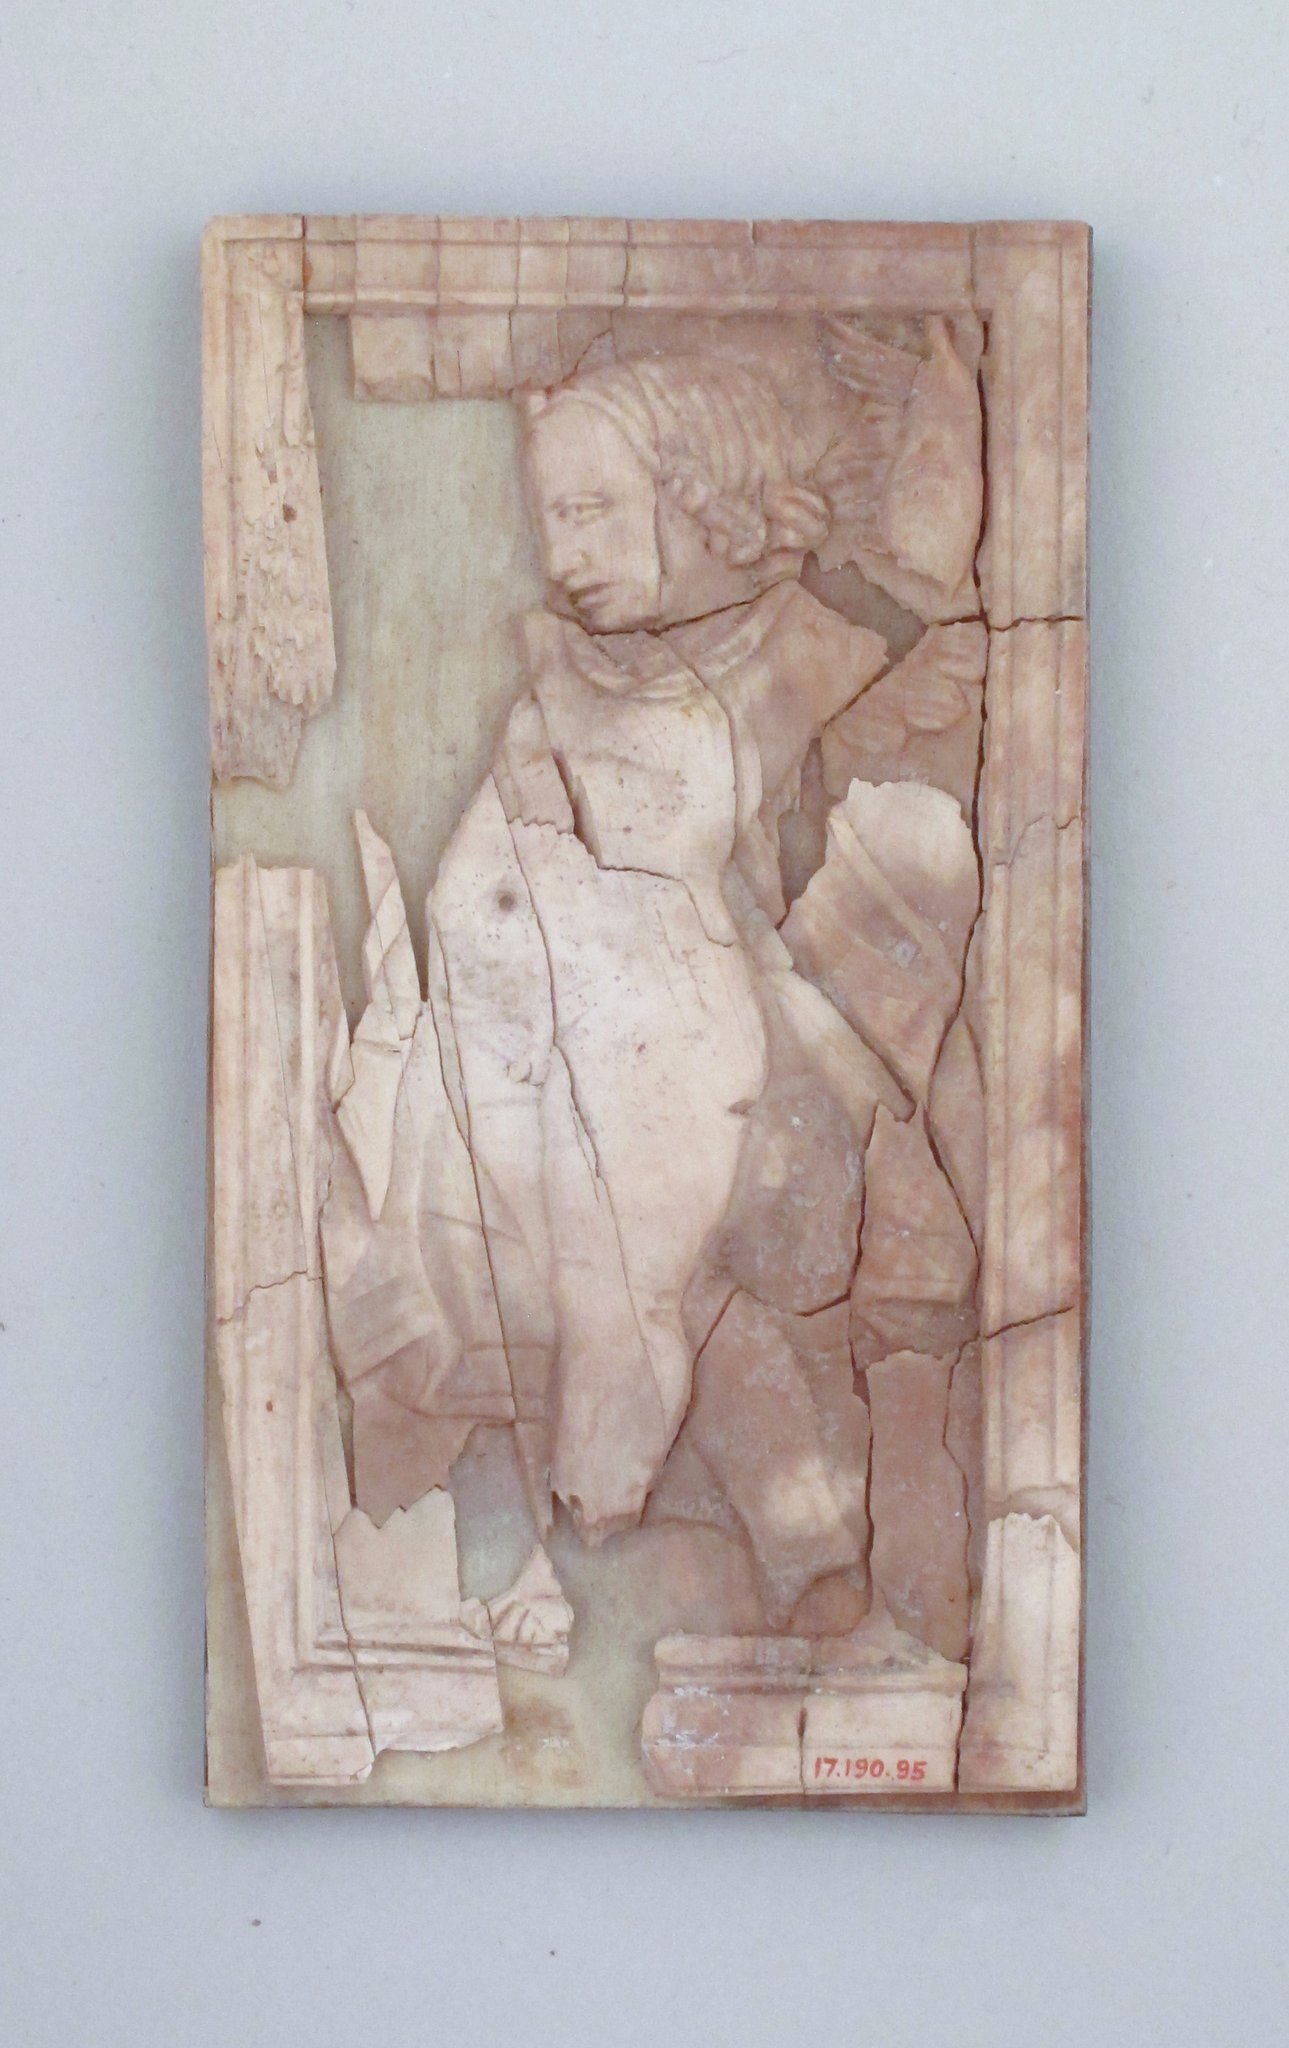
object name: relief from casket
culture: roman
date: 670 BCE-330 CE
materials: ivory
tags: eros